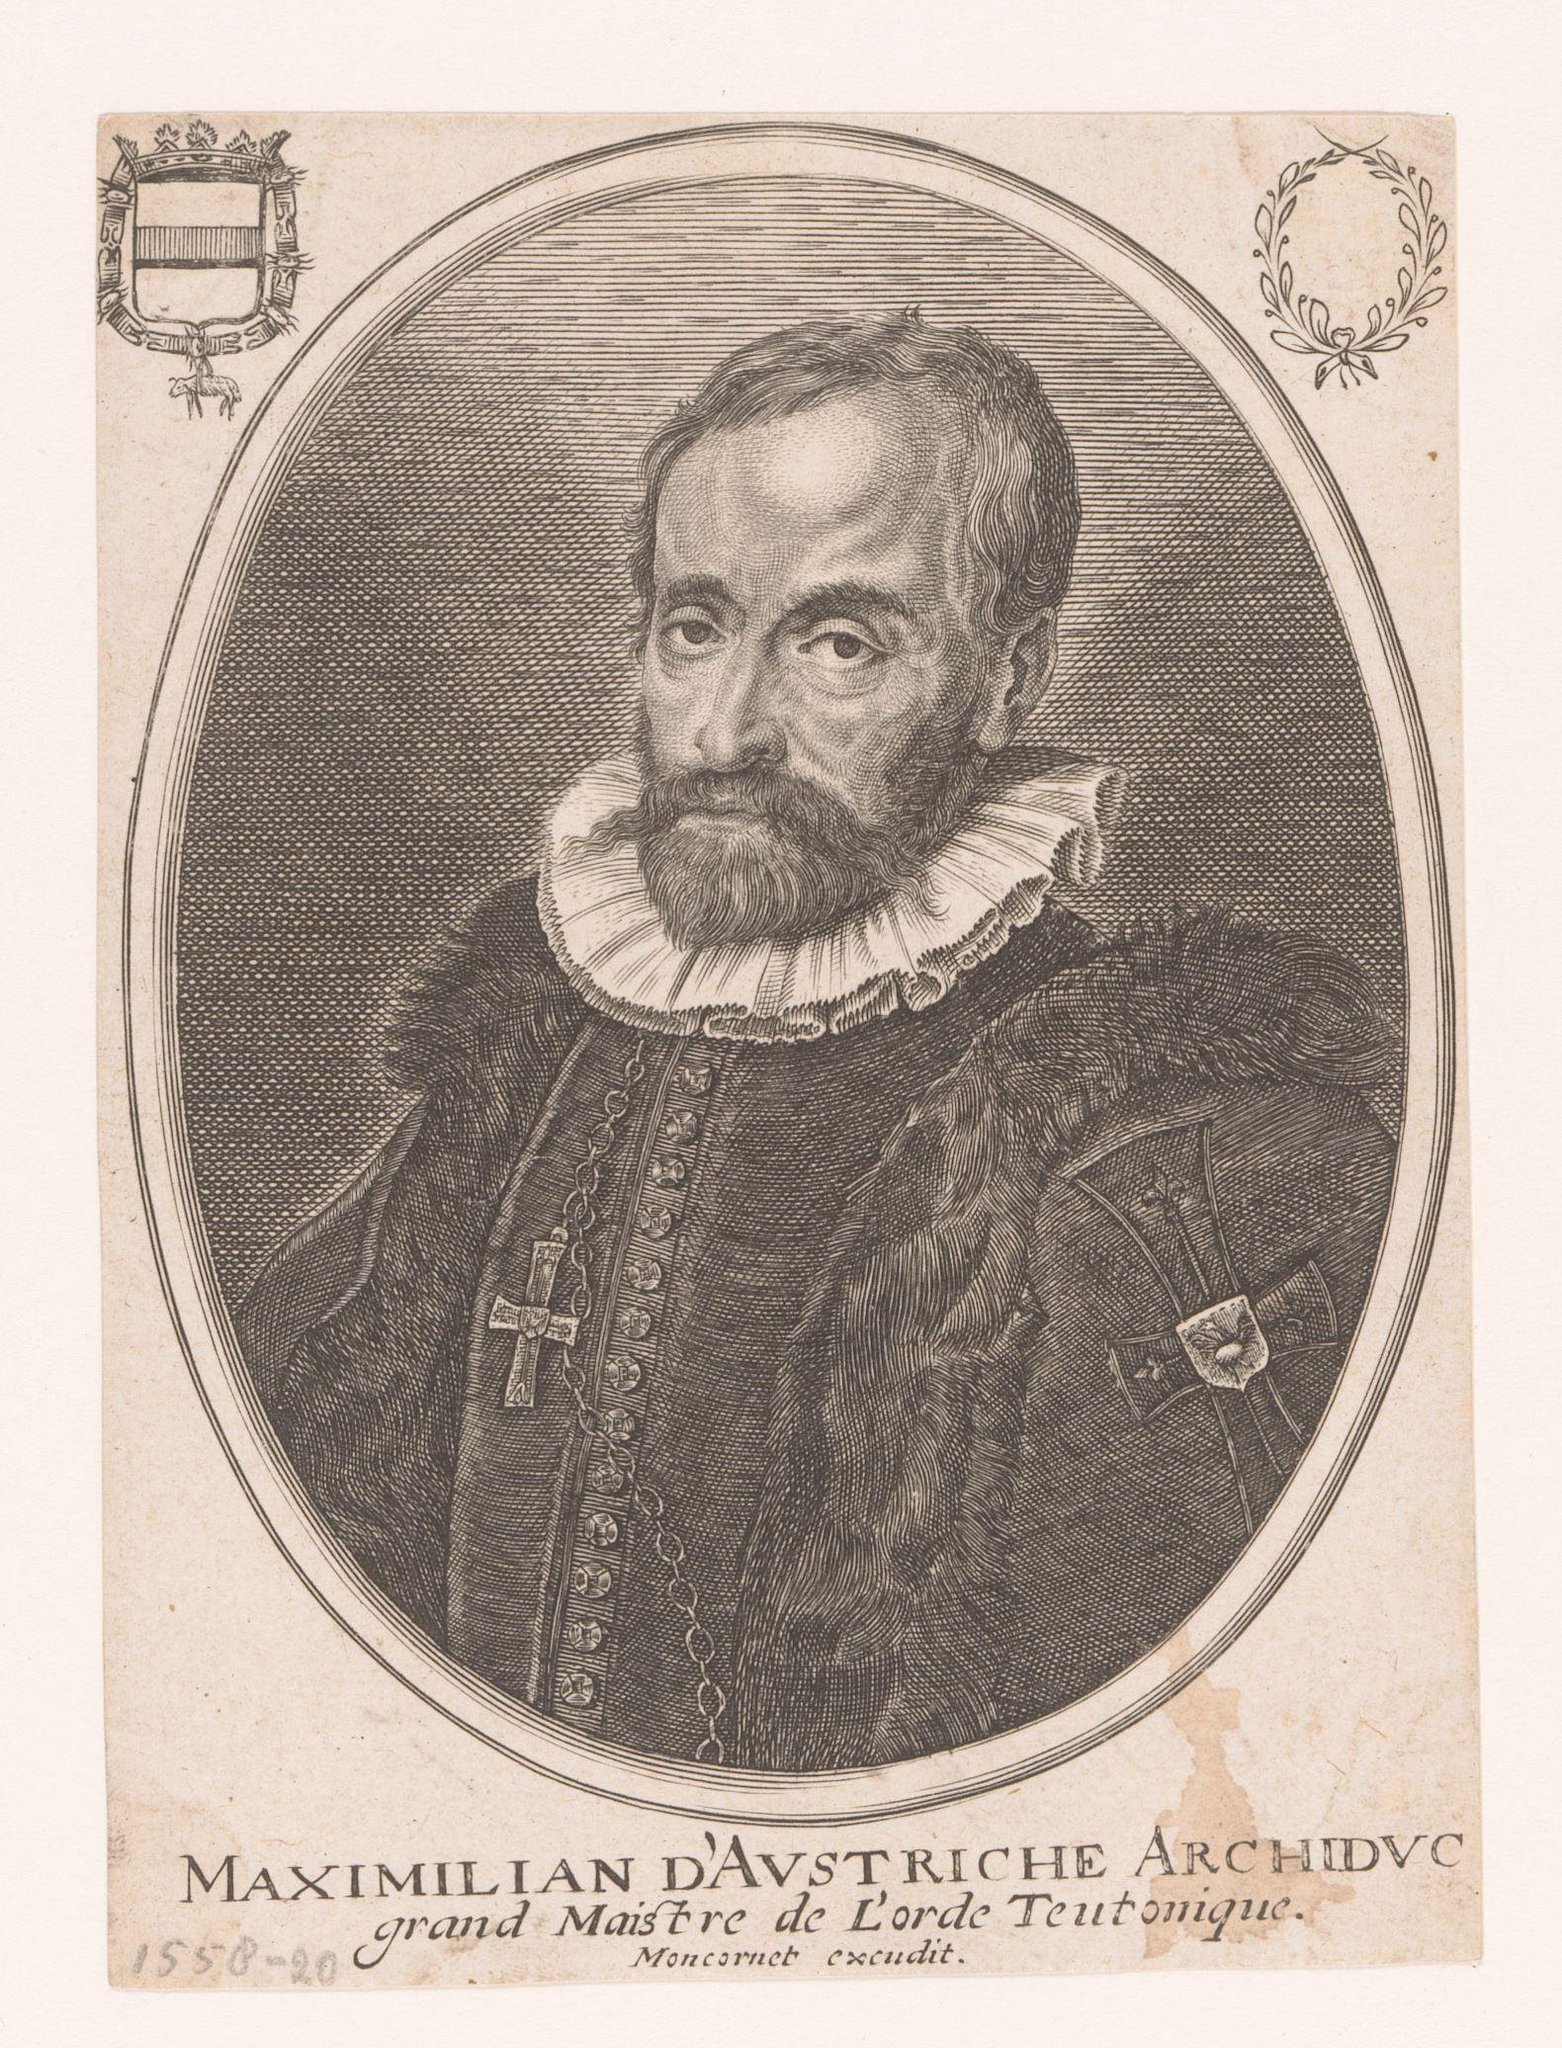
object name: print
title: Portret van Maximiliaan III van Oostenrijk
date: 1610-1668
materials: paper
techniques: engraving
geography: paris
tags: vienna, maximiliaan iii (aartshertog van oostenrijk), historical persons, nobility and patriciate; chivalry, knighthood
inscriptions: collector's mark: Lugt 2228